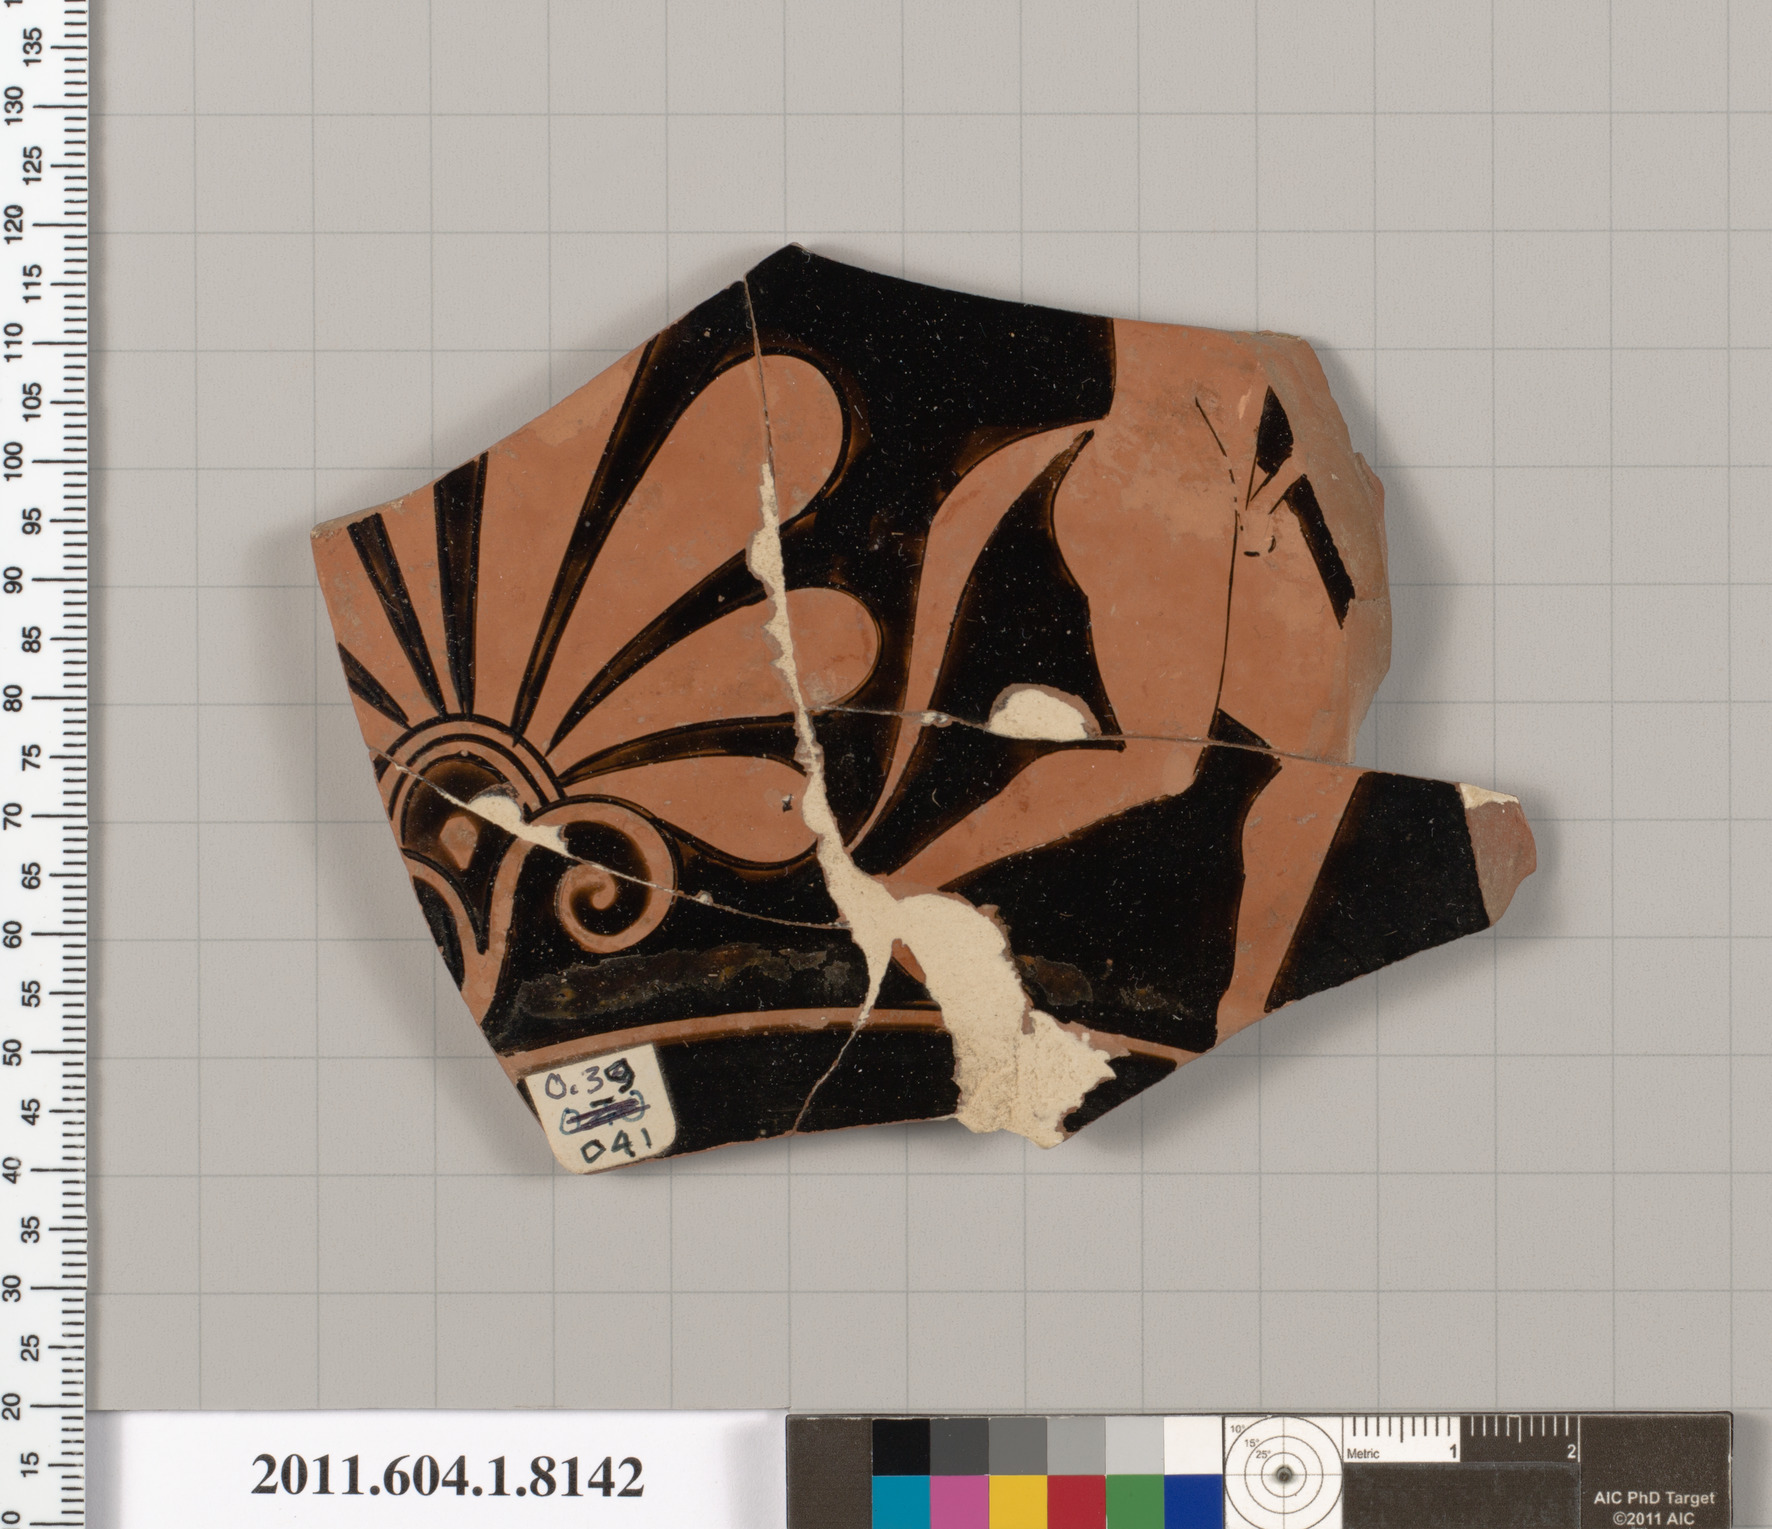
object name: kylix fragment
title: Terracotta fragment of a kylix (drinking cup)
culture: greek, attic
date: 520-510 BCE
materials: terracotta